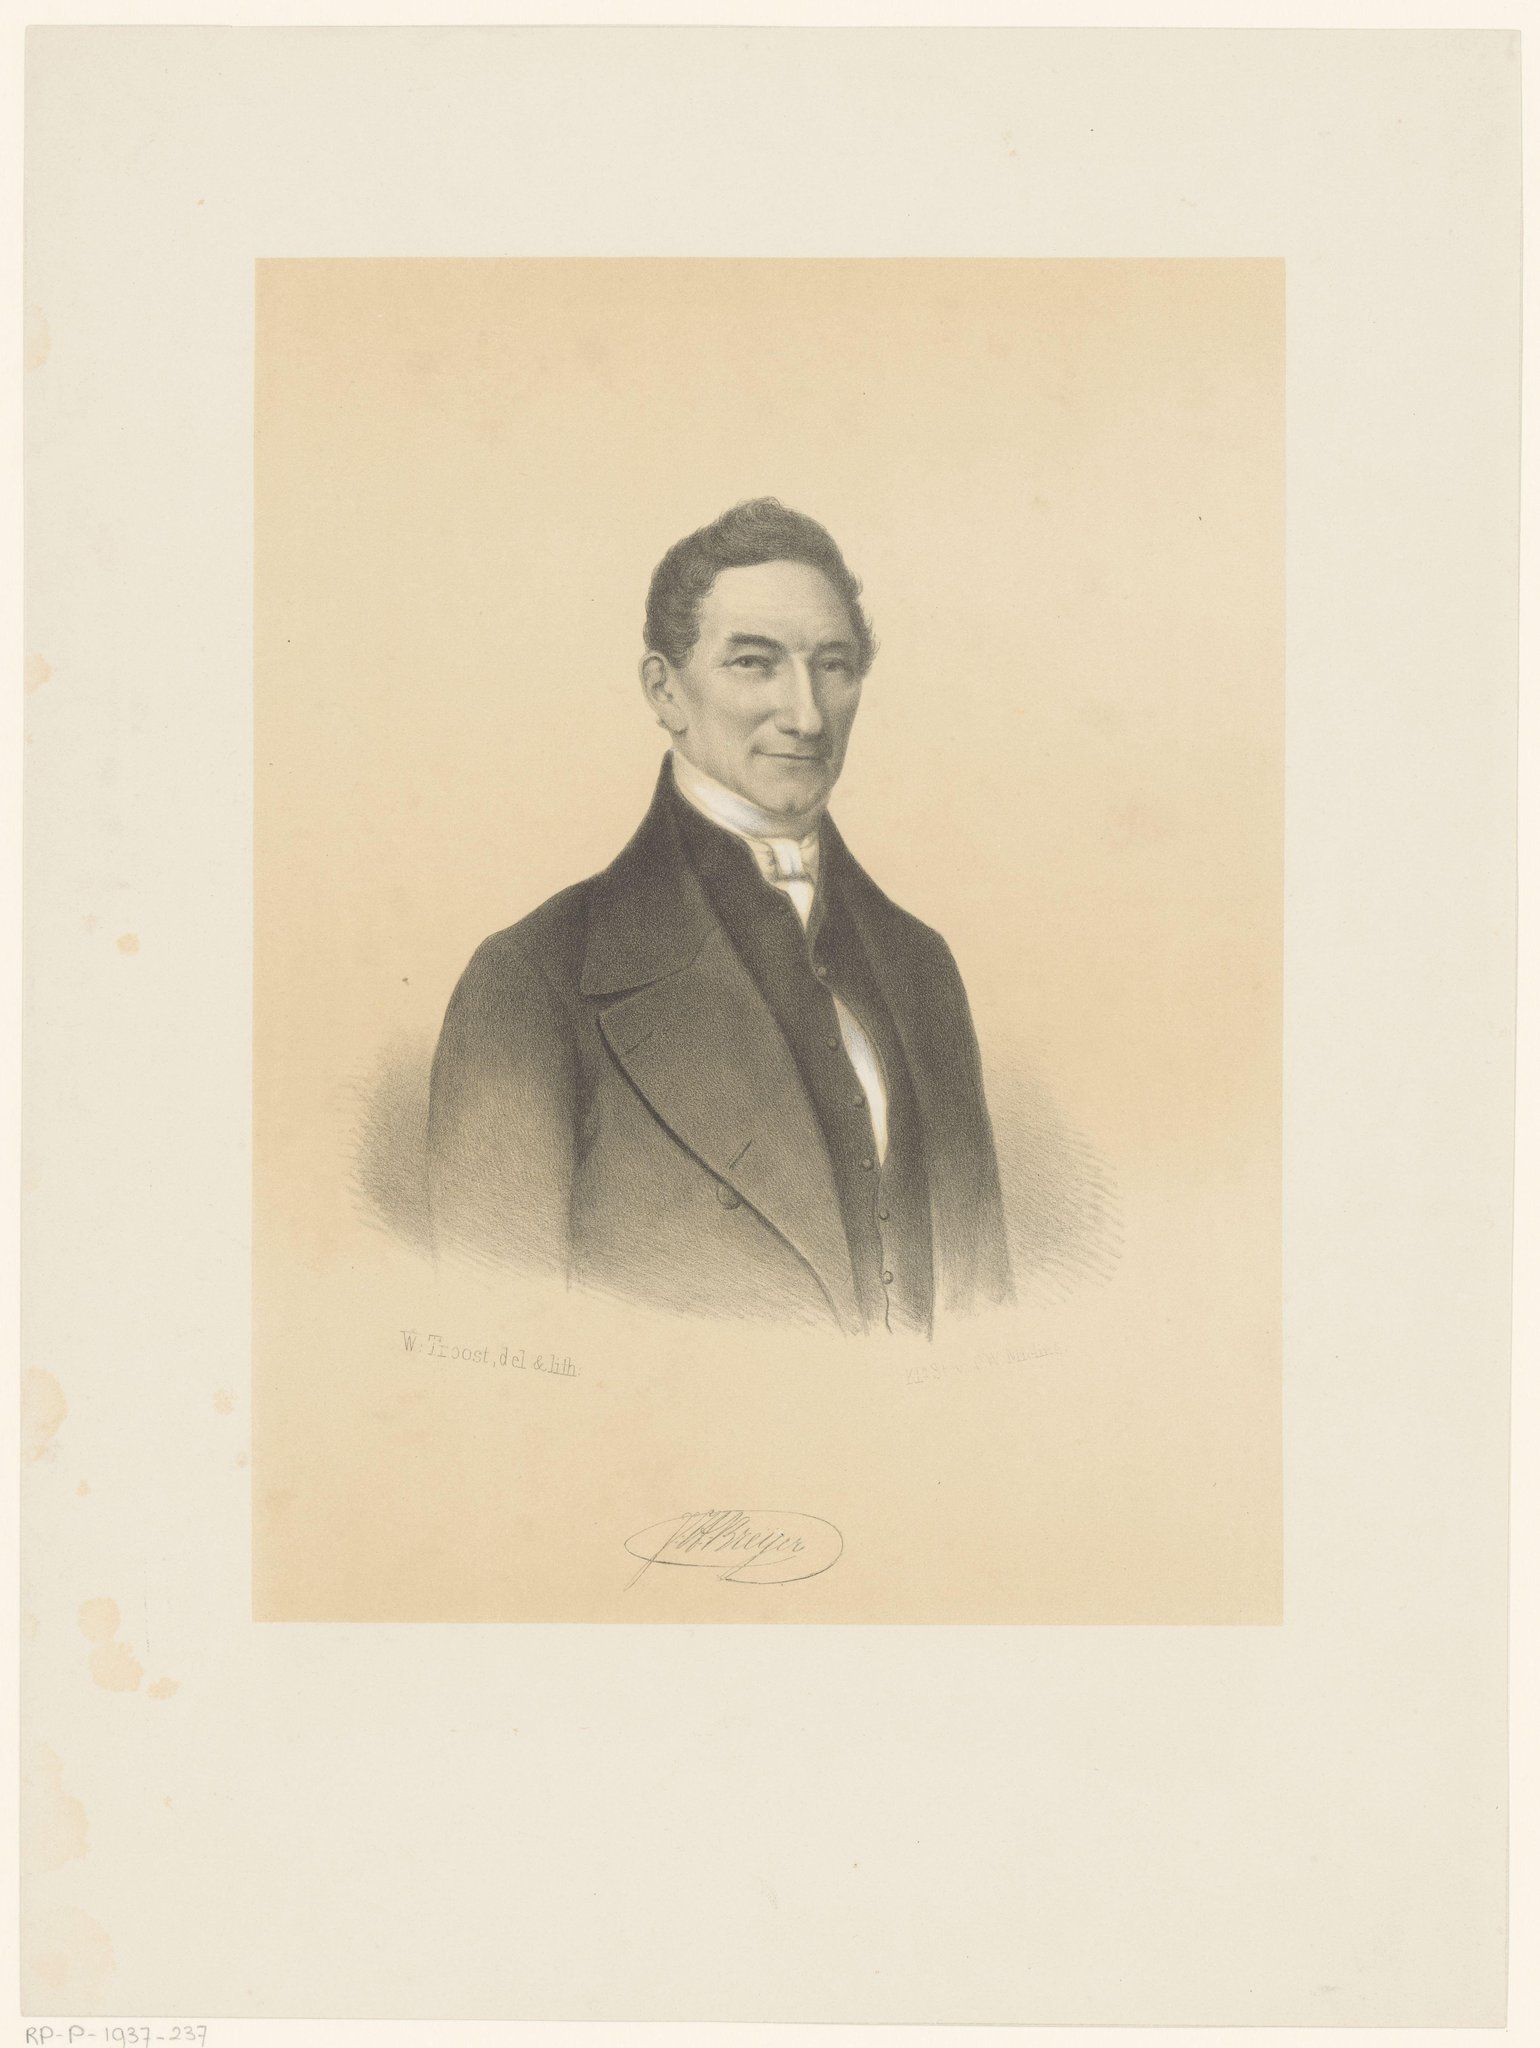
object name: print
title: Portret van Jan Hendrik Breijer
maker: willem troost (ii)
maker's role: draughtsman, painter, print maker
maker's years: 1812-1893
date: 1847-1865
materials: paper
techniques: tone lithography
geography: the hague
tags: arnhem, draughtsman, historical persons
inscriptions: collector's mark: Lugt 2228, collector's mark: Lugt 2760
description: Onder het portret de signatuur van de geportretteerde.